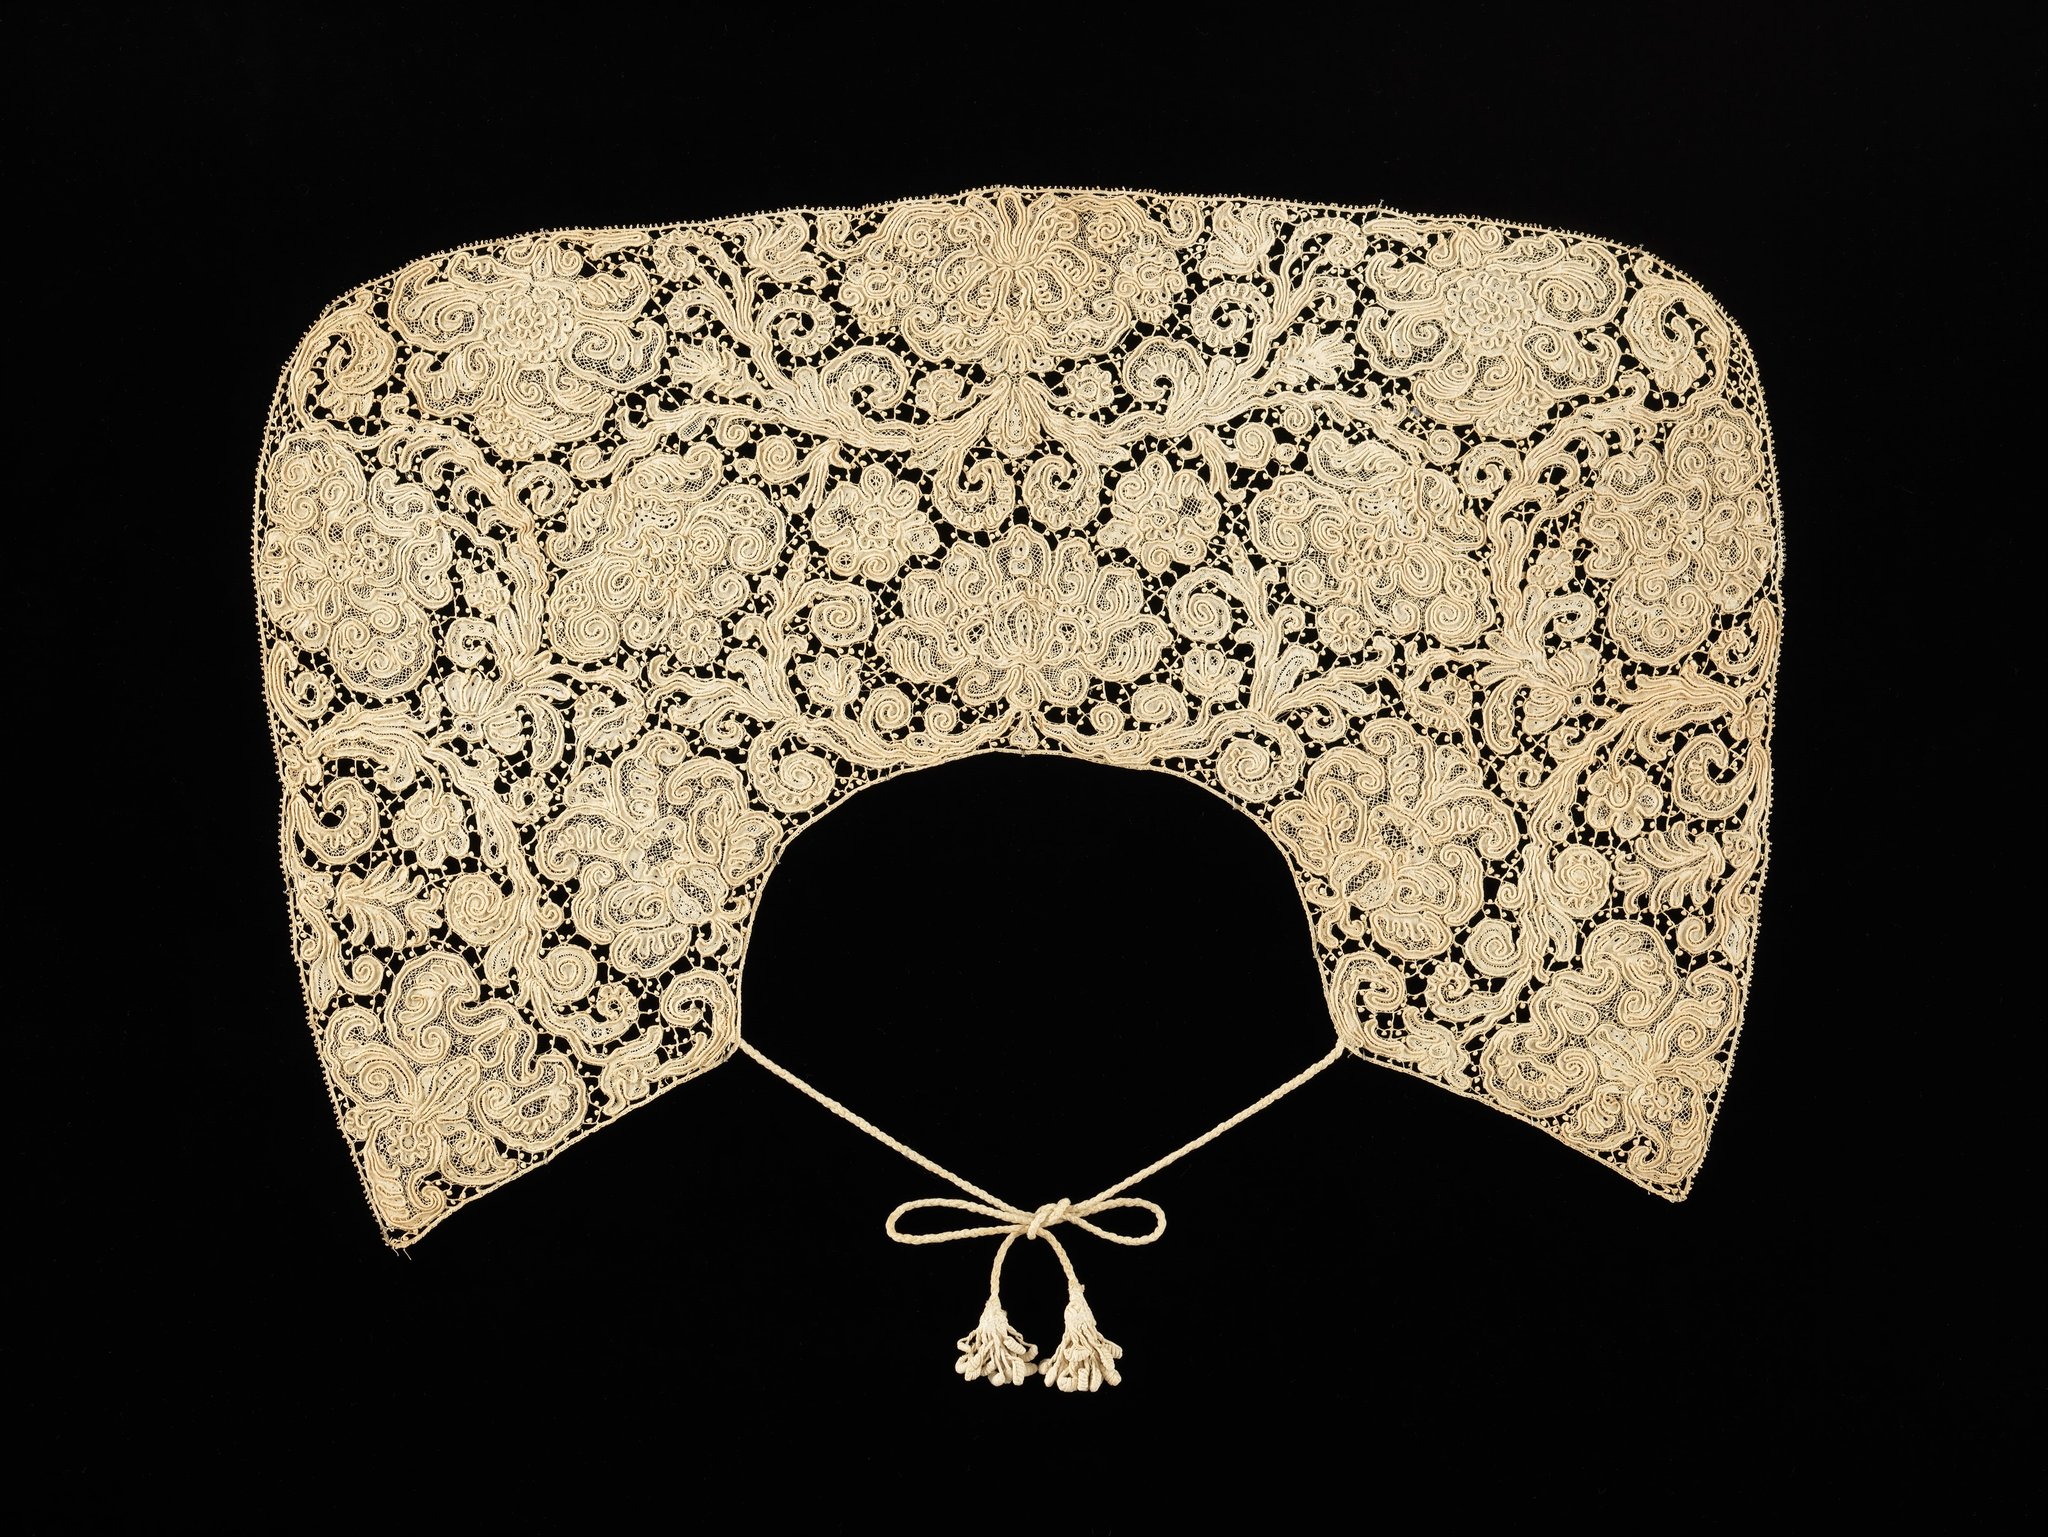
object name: collar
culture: spanish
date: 1667-1700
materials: linen